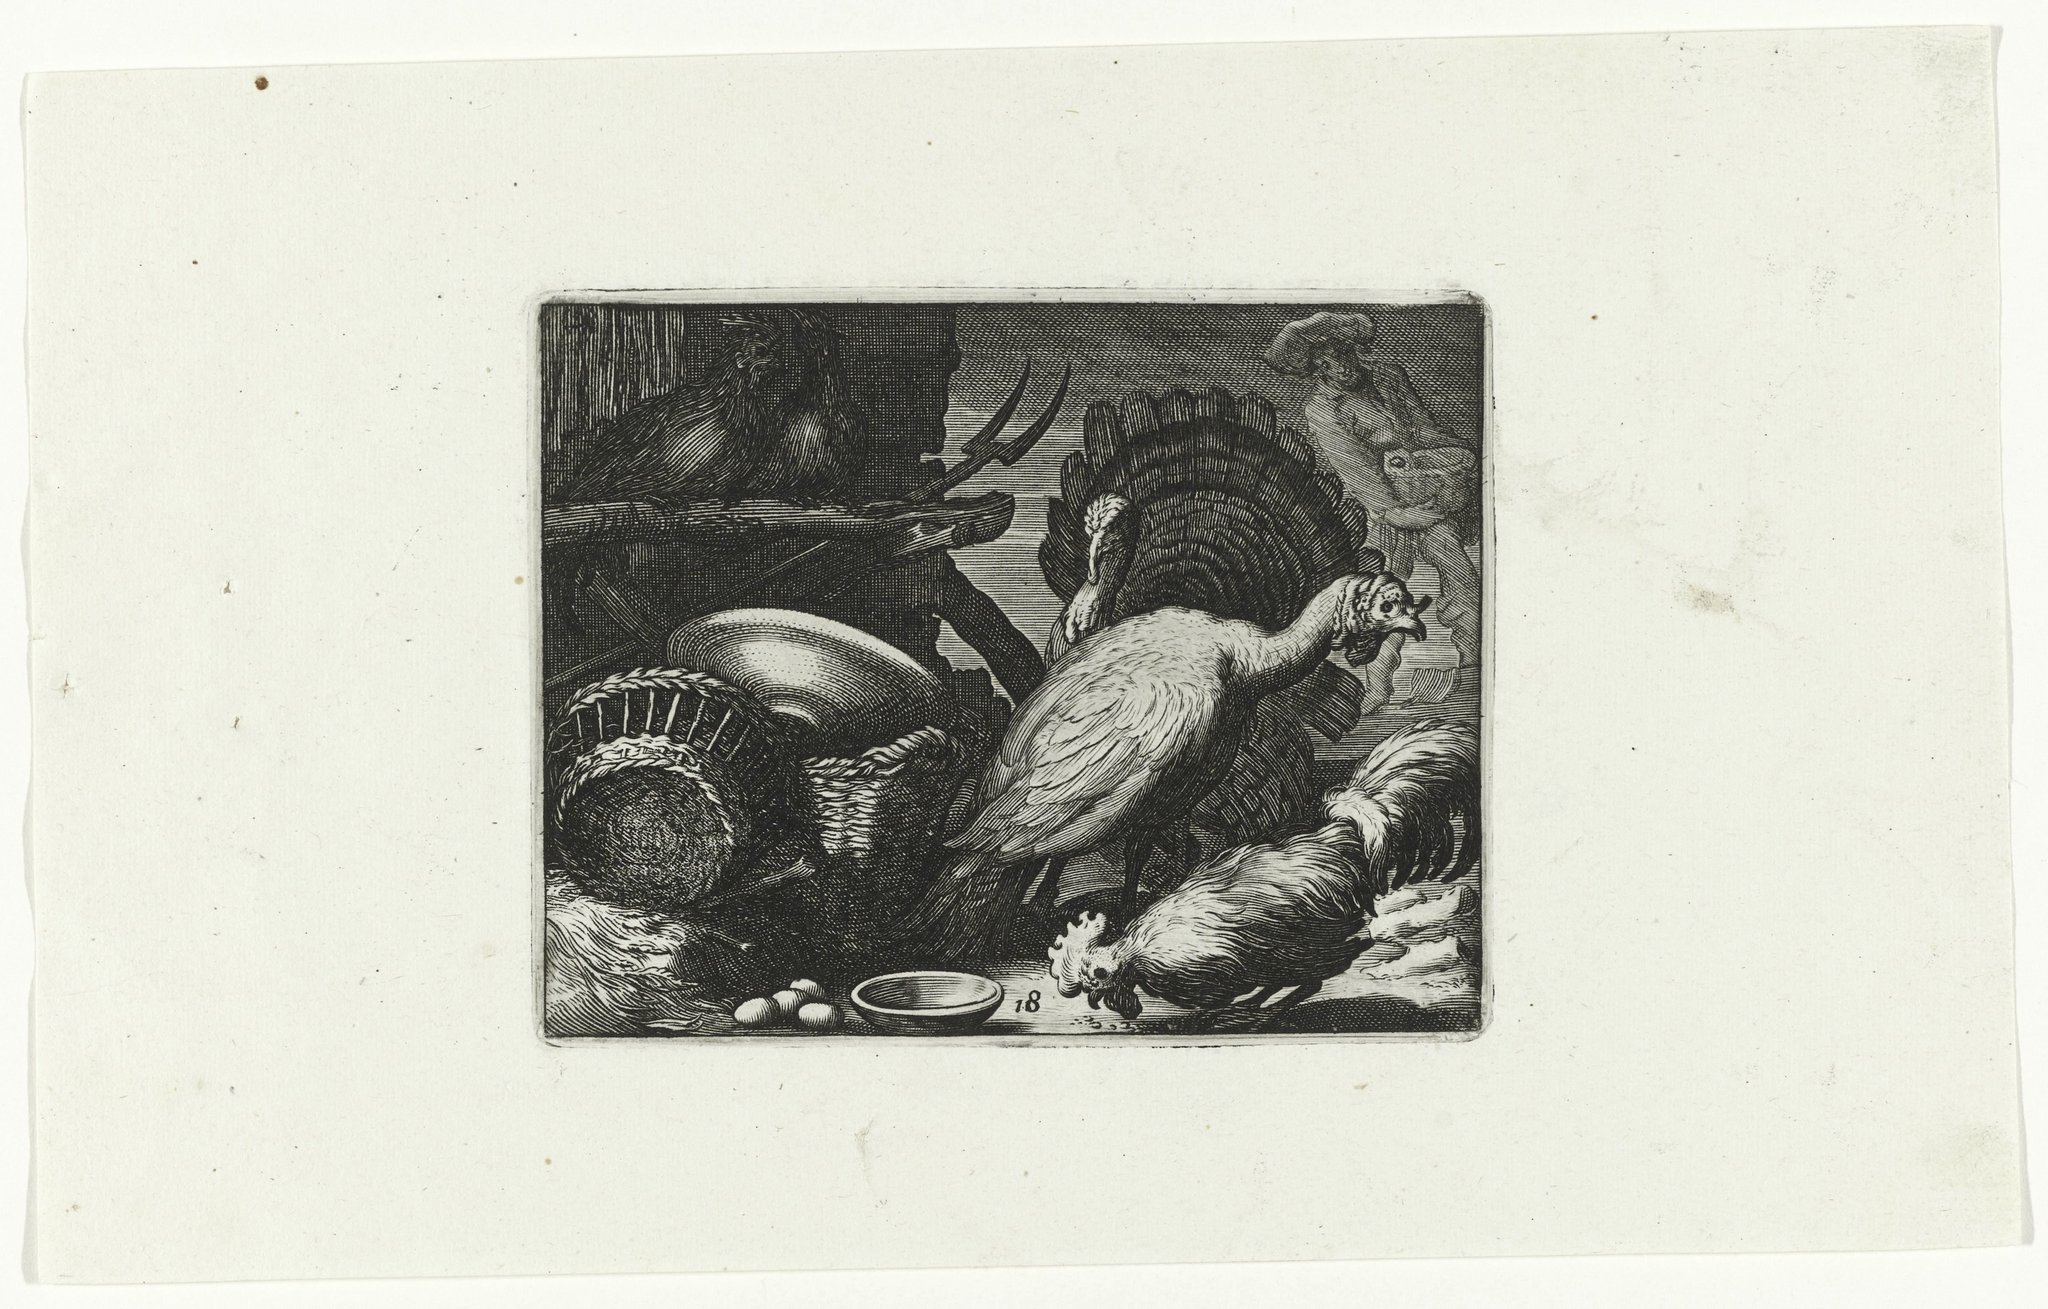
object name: print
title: Pastoralen en dieren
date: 1611-1650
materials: paper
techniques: engraving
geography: netherlands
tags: fowl (cock, hen, chicken, etc.), walker and runner birds: turkey